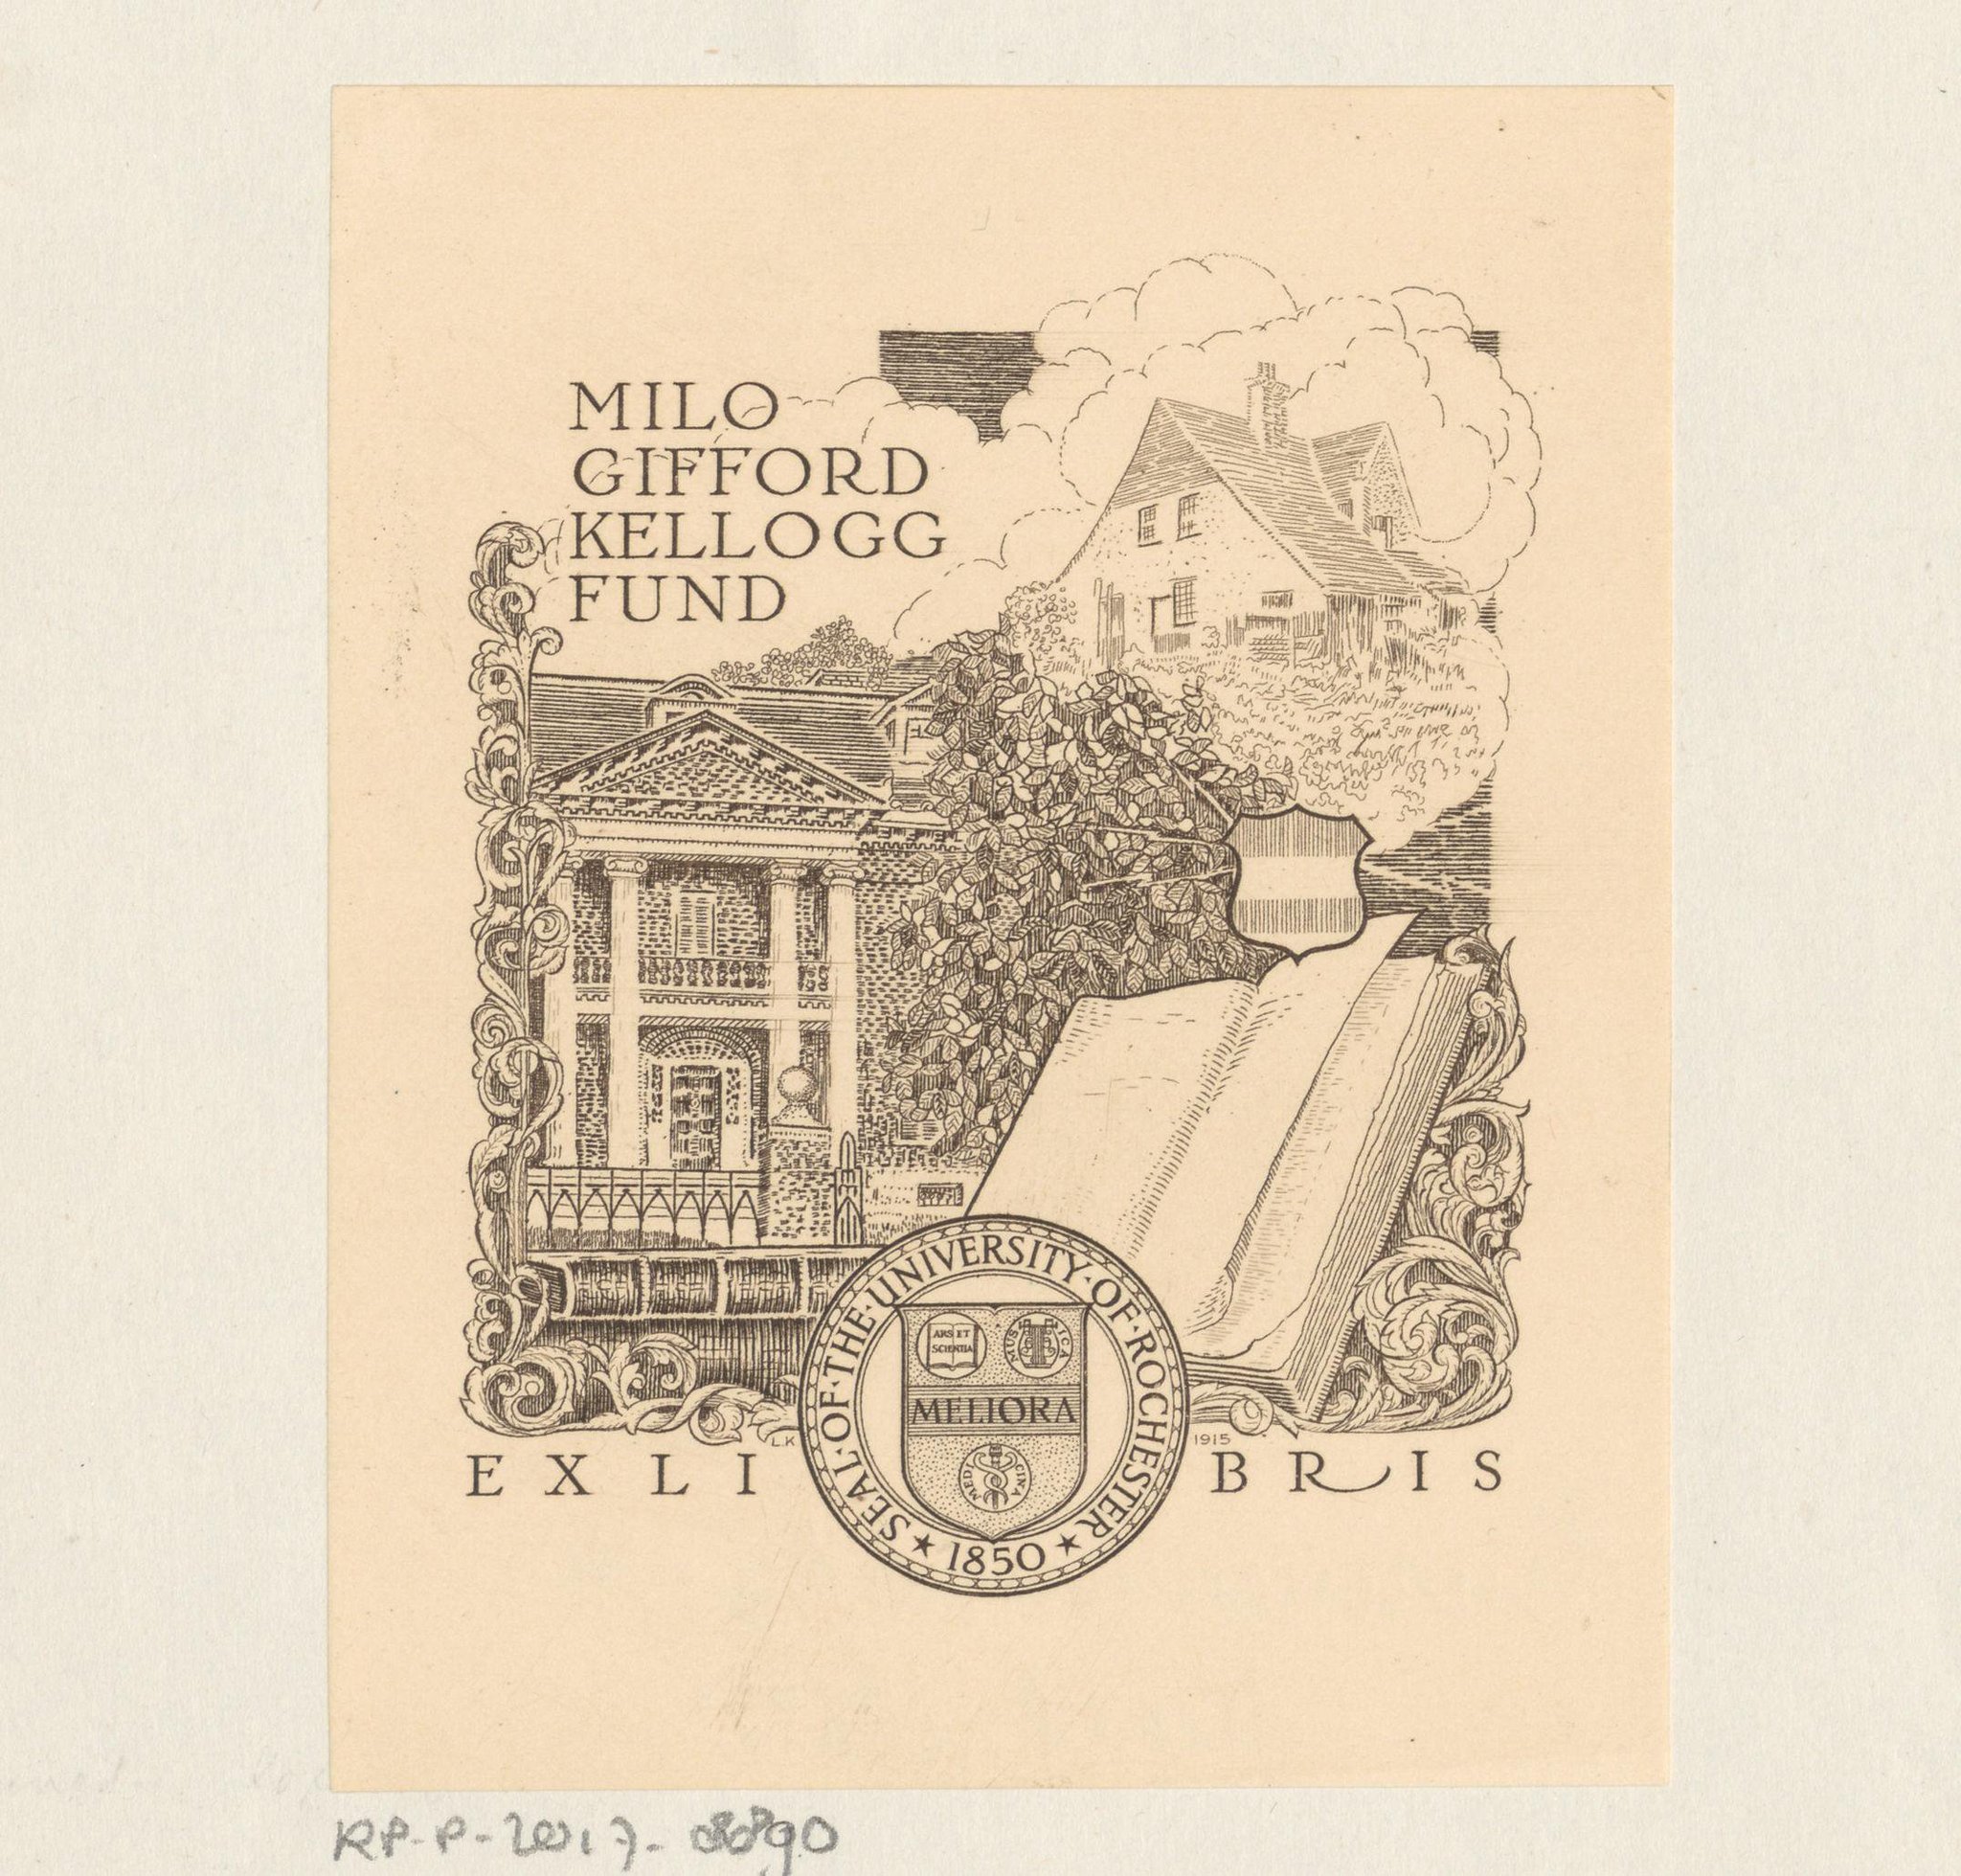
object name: bookplate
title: Ex libris van het Milo Gifford Kellogg Fund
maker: lawrence kennedy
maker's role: print maker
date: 1915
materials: paper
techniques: etching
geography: north and central america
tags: university, book, villa, armorial bearing, heraldry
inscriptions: inscription: ‘Lawrence Kennedy sc./ second state’